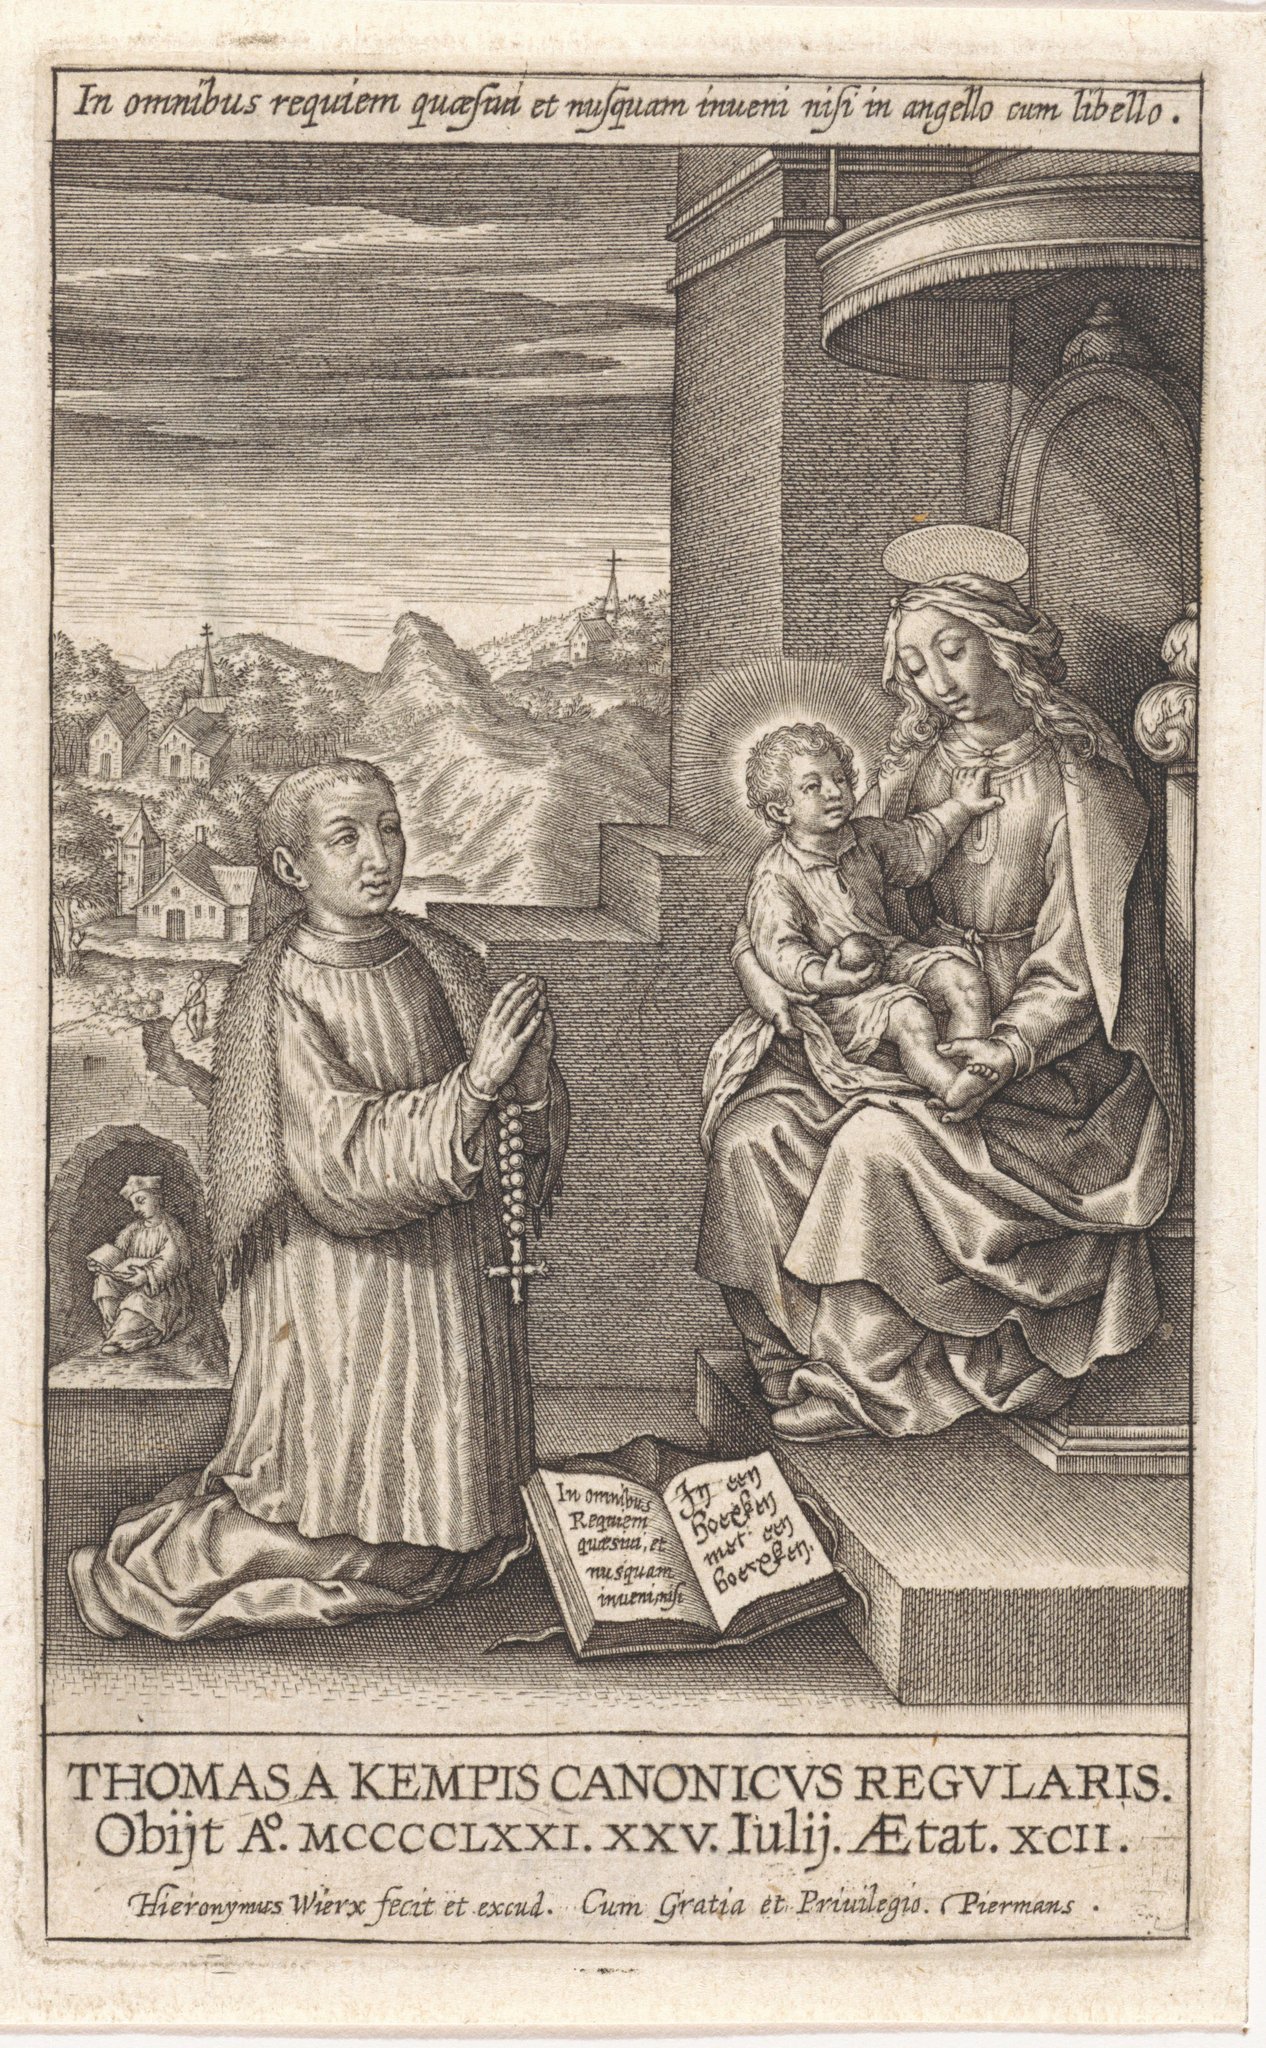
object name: print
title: Thomas à Kempis geknield voor Maria met het Christuskind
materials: paper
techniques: engraving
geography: antwerp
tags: priest, thomas à kempis, madonna: mary sitting or enthroned, the christ-child in her lap (or in front of her bosom) (mary sometimes represented half-length), theologian, book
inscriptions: collector's mark: Lugt 2228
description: Thomas à Kempis knielt in aanbidding voor Maria en het Christuskind. Aan zijn knieën een opengeslagen boek. Op de achtergrond een gezicht op een landschap met een kerk, en meer naar de voorgrond Thomas à Kempis in een grot. De prent heeft een bovenschrift in het Latijn. In de marge de biografische gegevens van de geportretteerde in het Latijn.